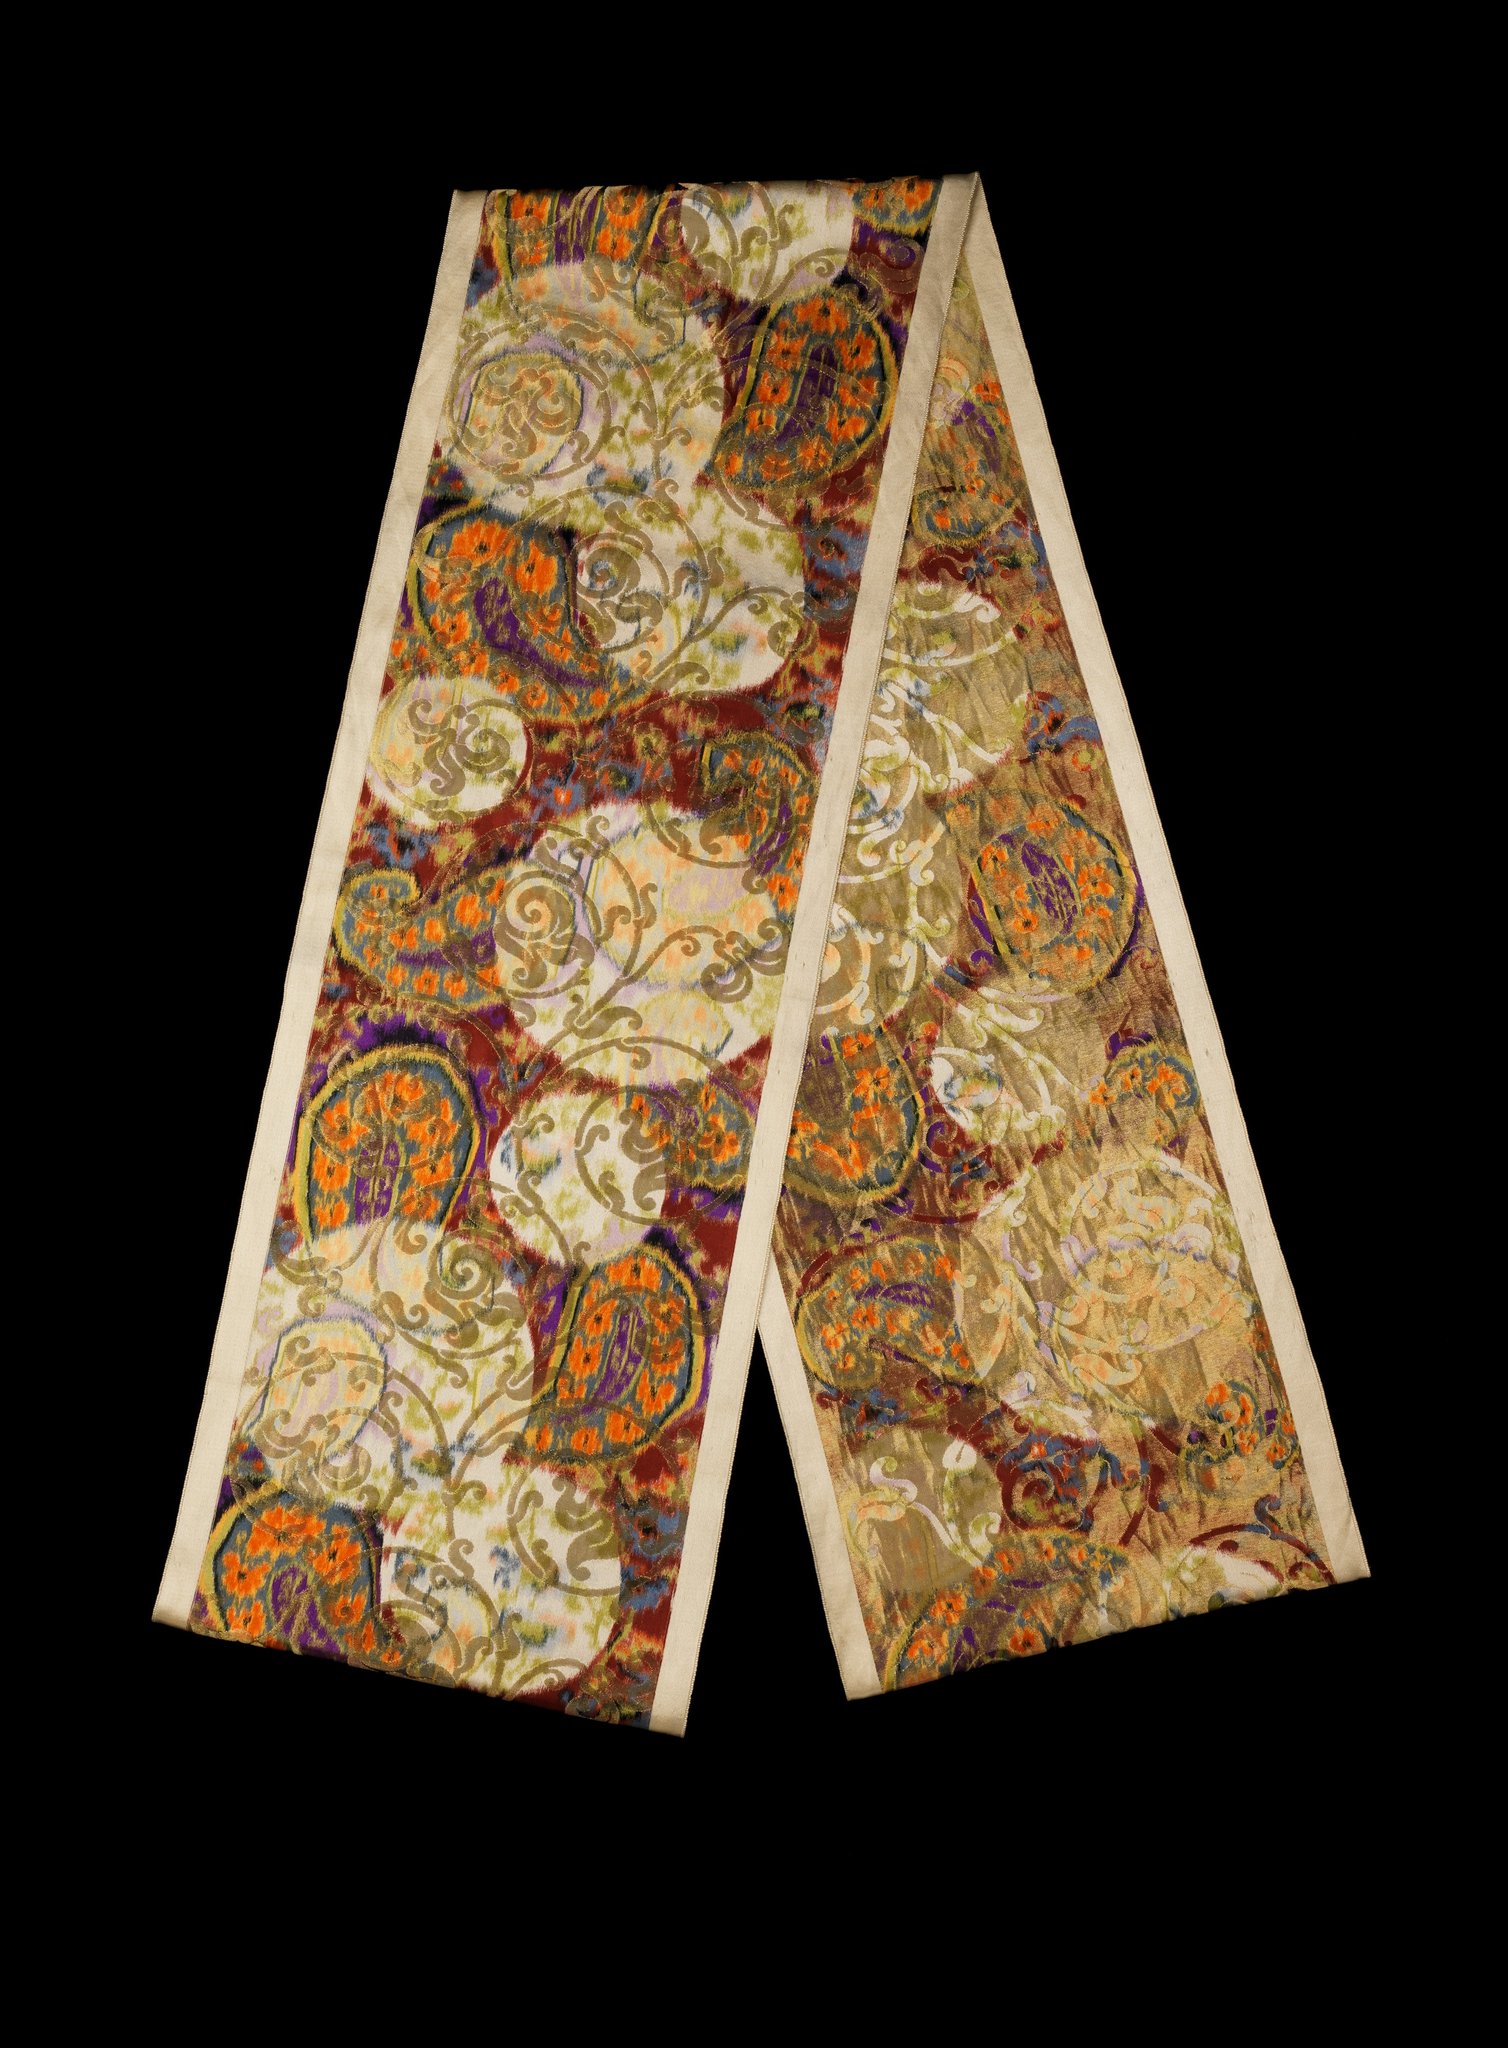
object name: ribbon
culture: french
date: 1870-1890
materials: metal, silk